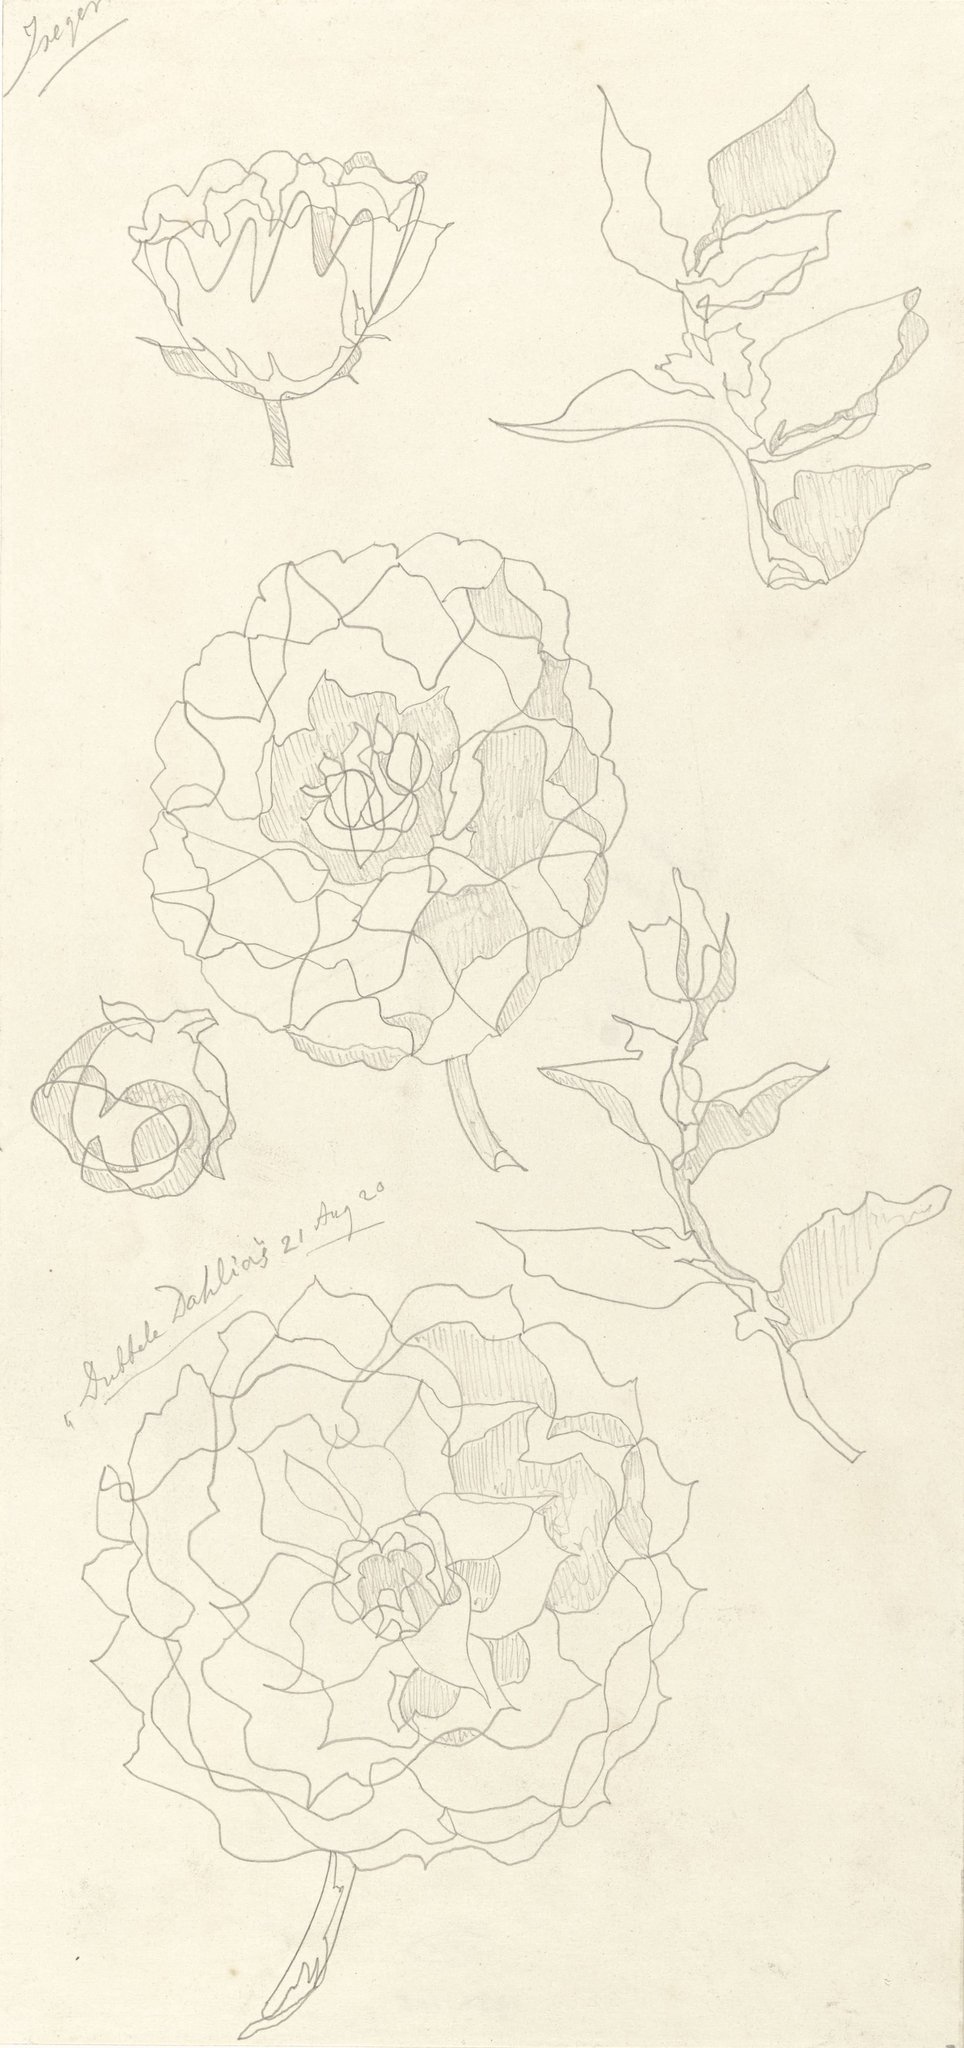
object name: drawing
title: Ontwerp voor aardewerkdecoratie Iseger: Dubbele Dahlia's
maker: theo colenbrander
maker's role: draughtsman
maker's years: 1841-1930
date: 1920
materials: paper, pencil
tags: flowers: dahlia, flowers ~ ornament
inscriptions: date: ‘21 Aug 20’